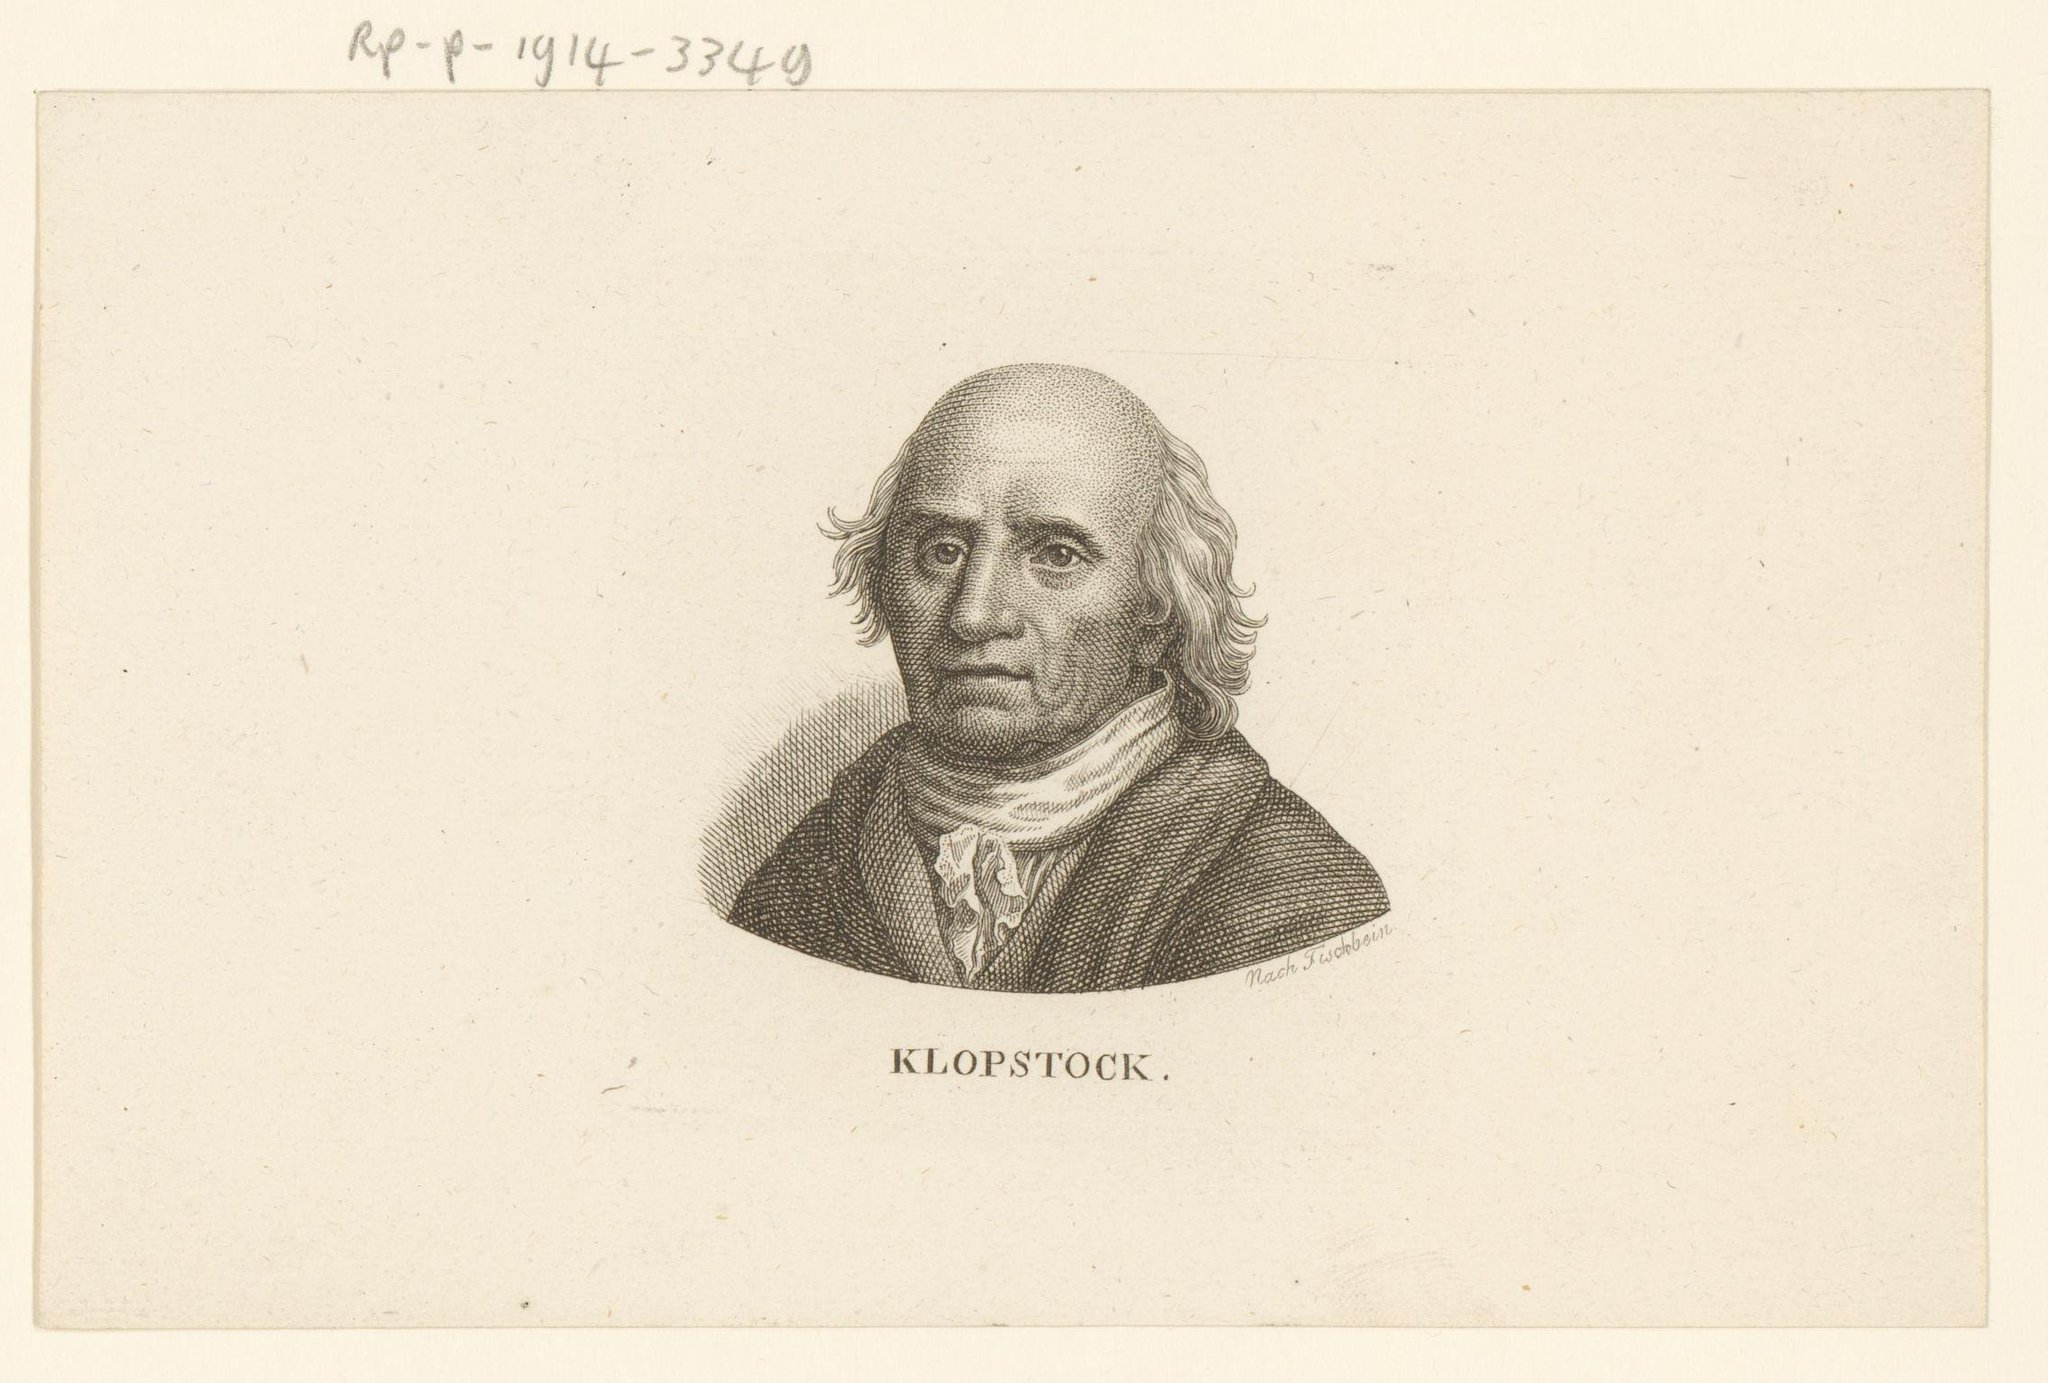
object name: print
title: Portret van Friedrich Gottlieb Klopstock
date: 1775-1840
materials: paper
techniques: engraving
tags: historical persons, portrait, self-portrait of artist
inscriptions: collector's mark: Lugt 2228